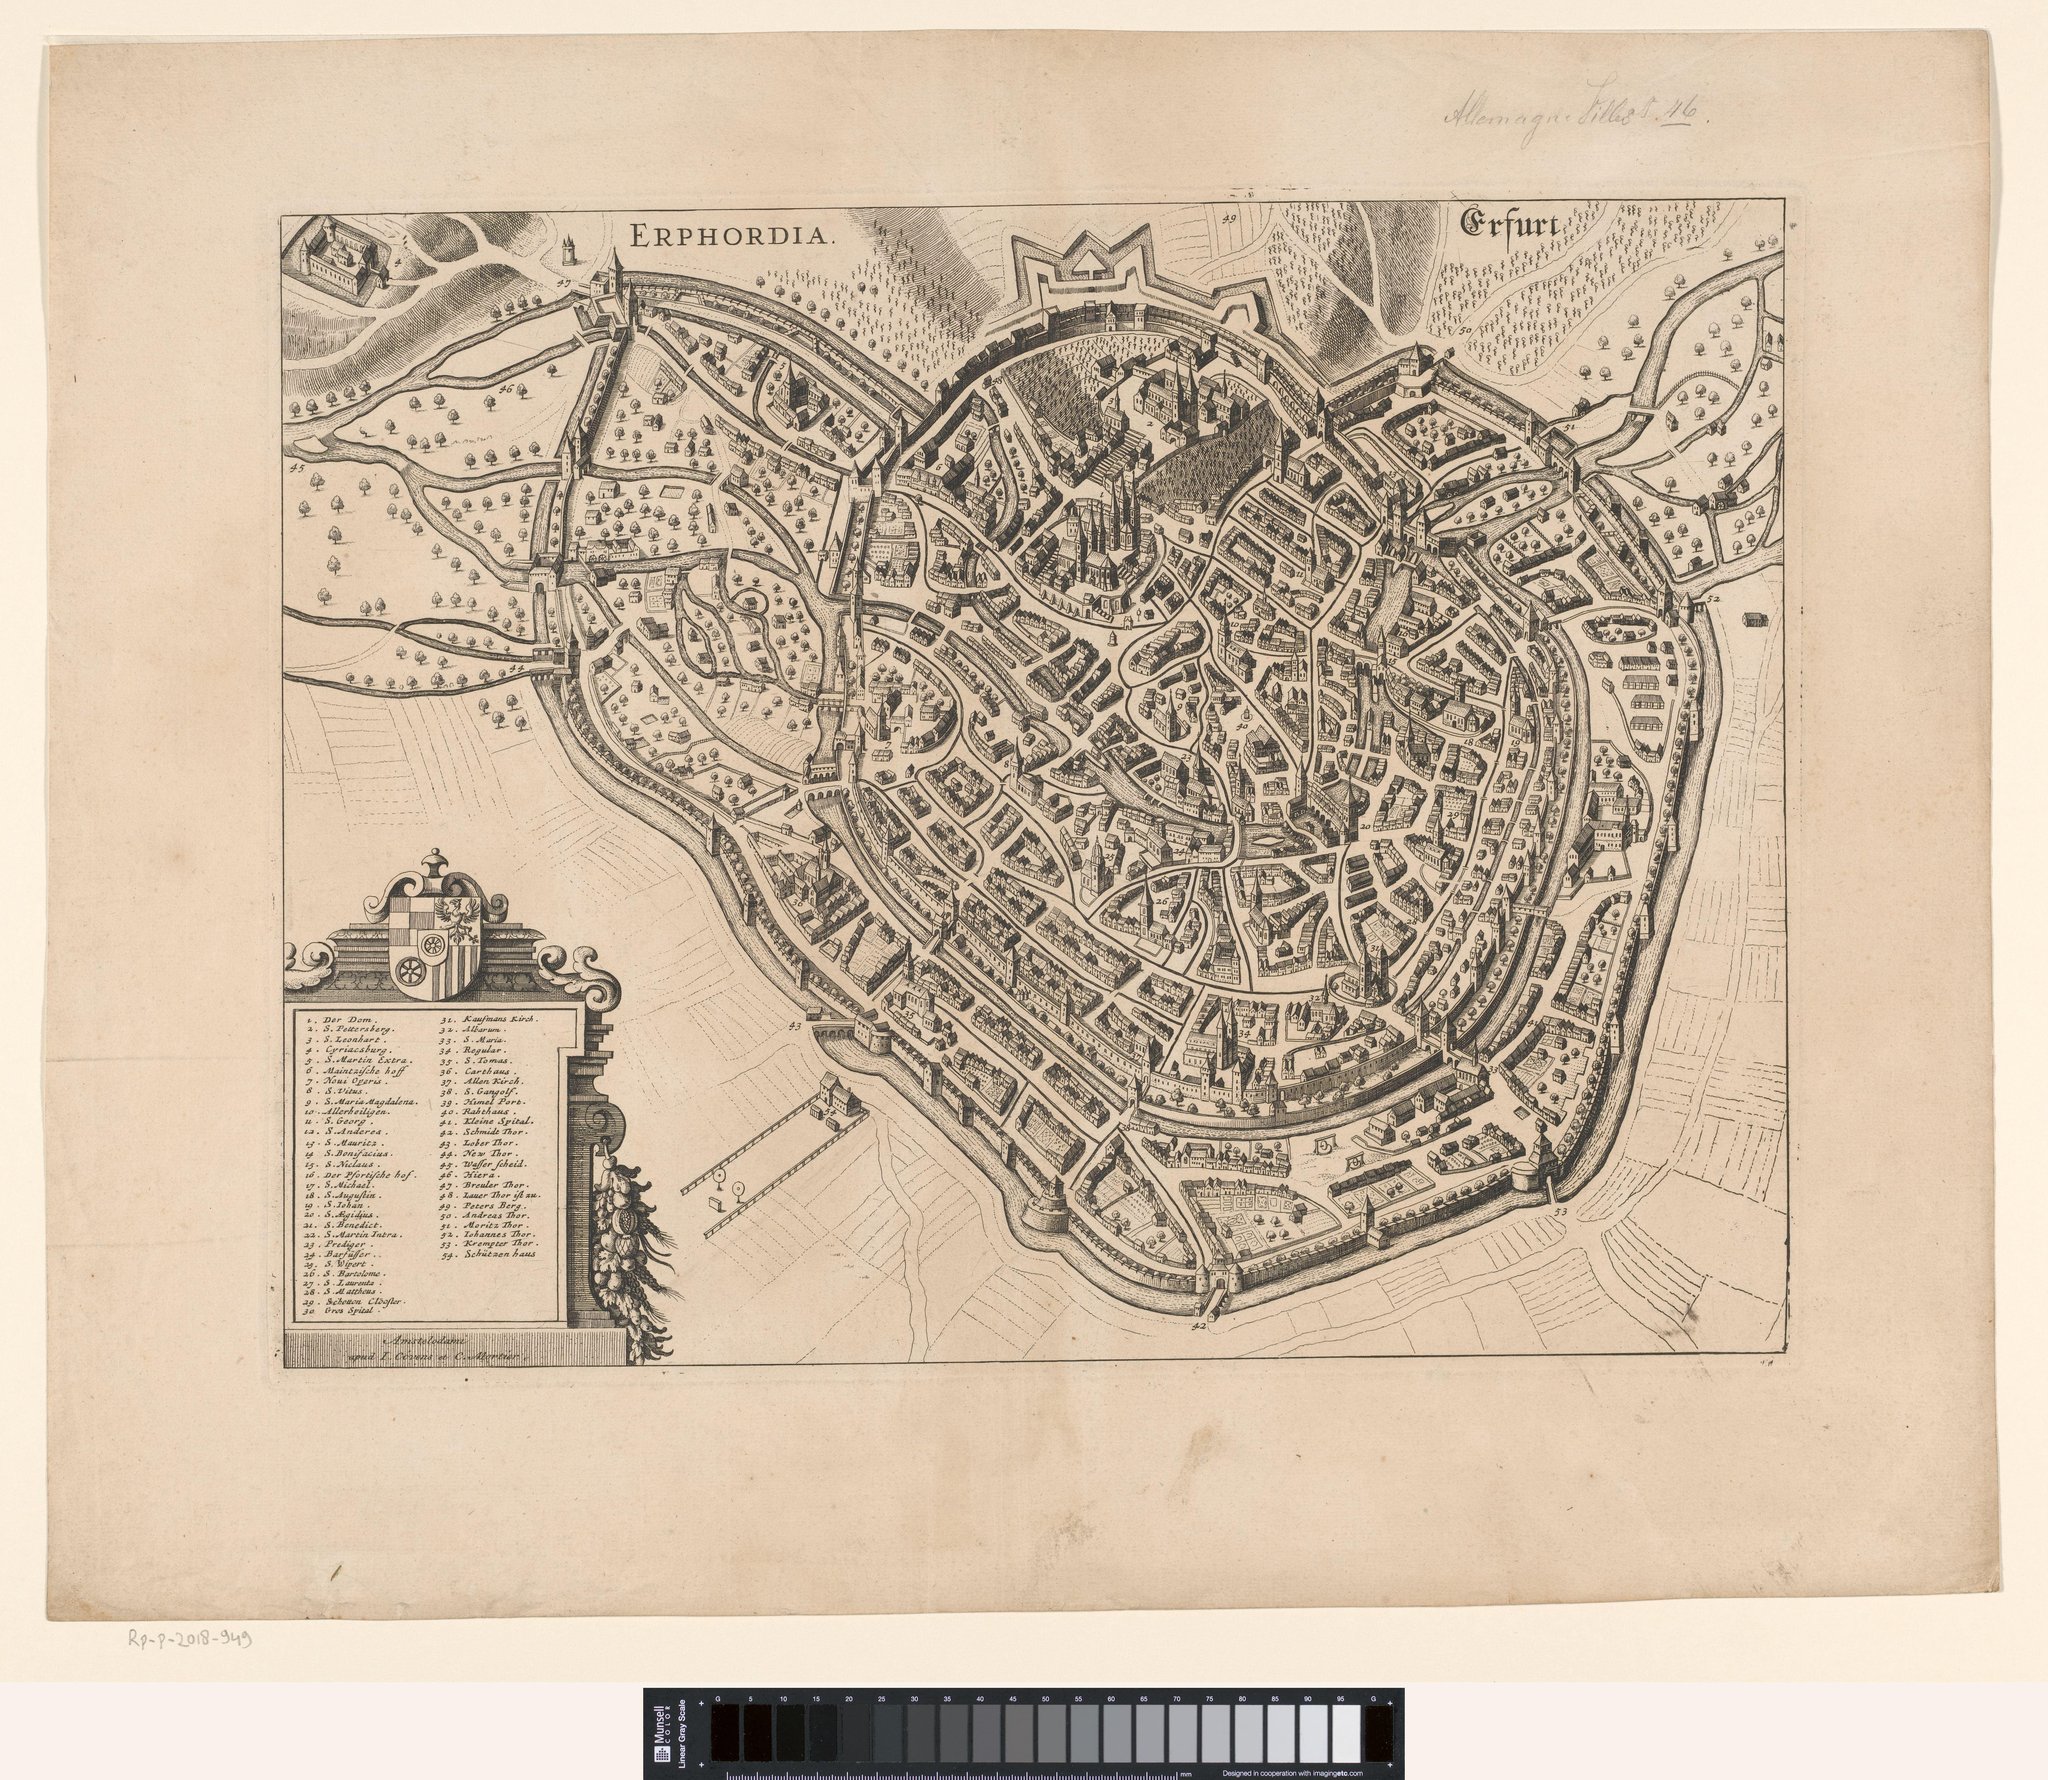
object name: print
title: Plattegrond van Erfurt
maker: Anonymous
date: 1657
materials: paper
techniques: engraving, etching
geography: amsterdam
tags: coat of arms (as symbol of the state, etc.) (+ city; municipal), maps of cities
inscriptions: collector's mark: Lugt 2228